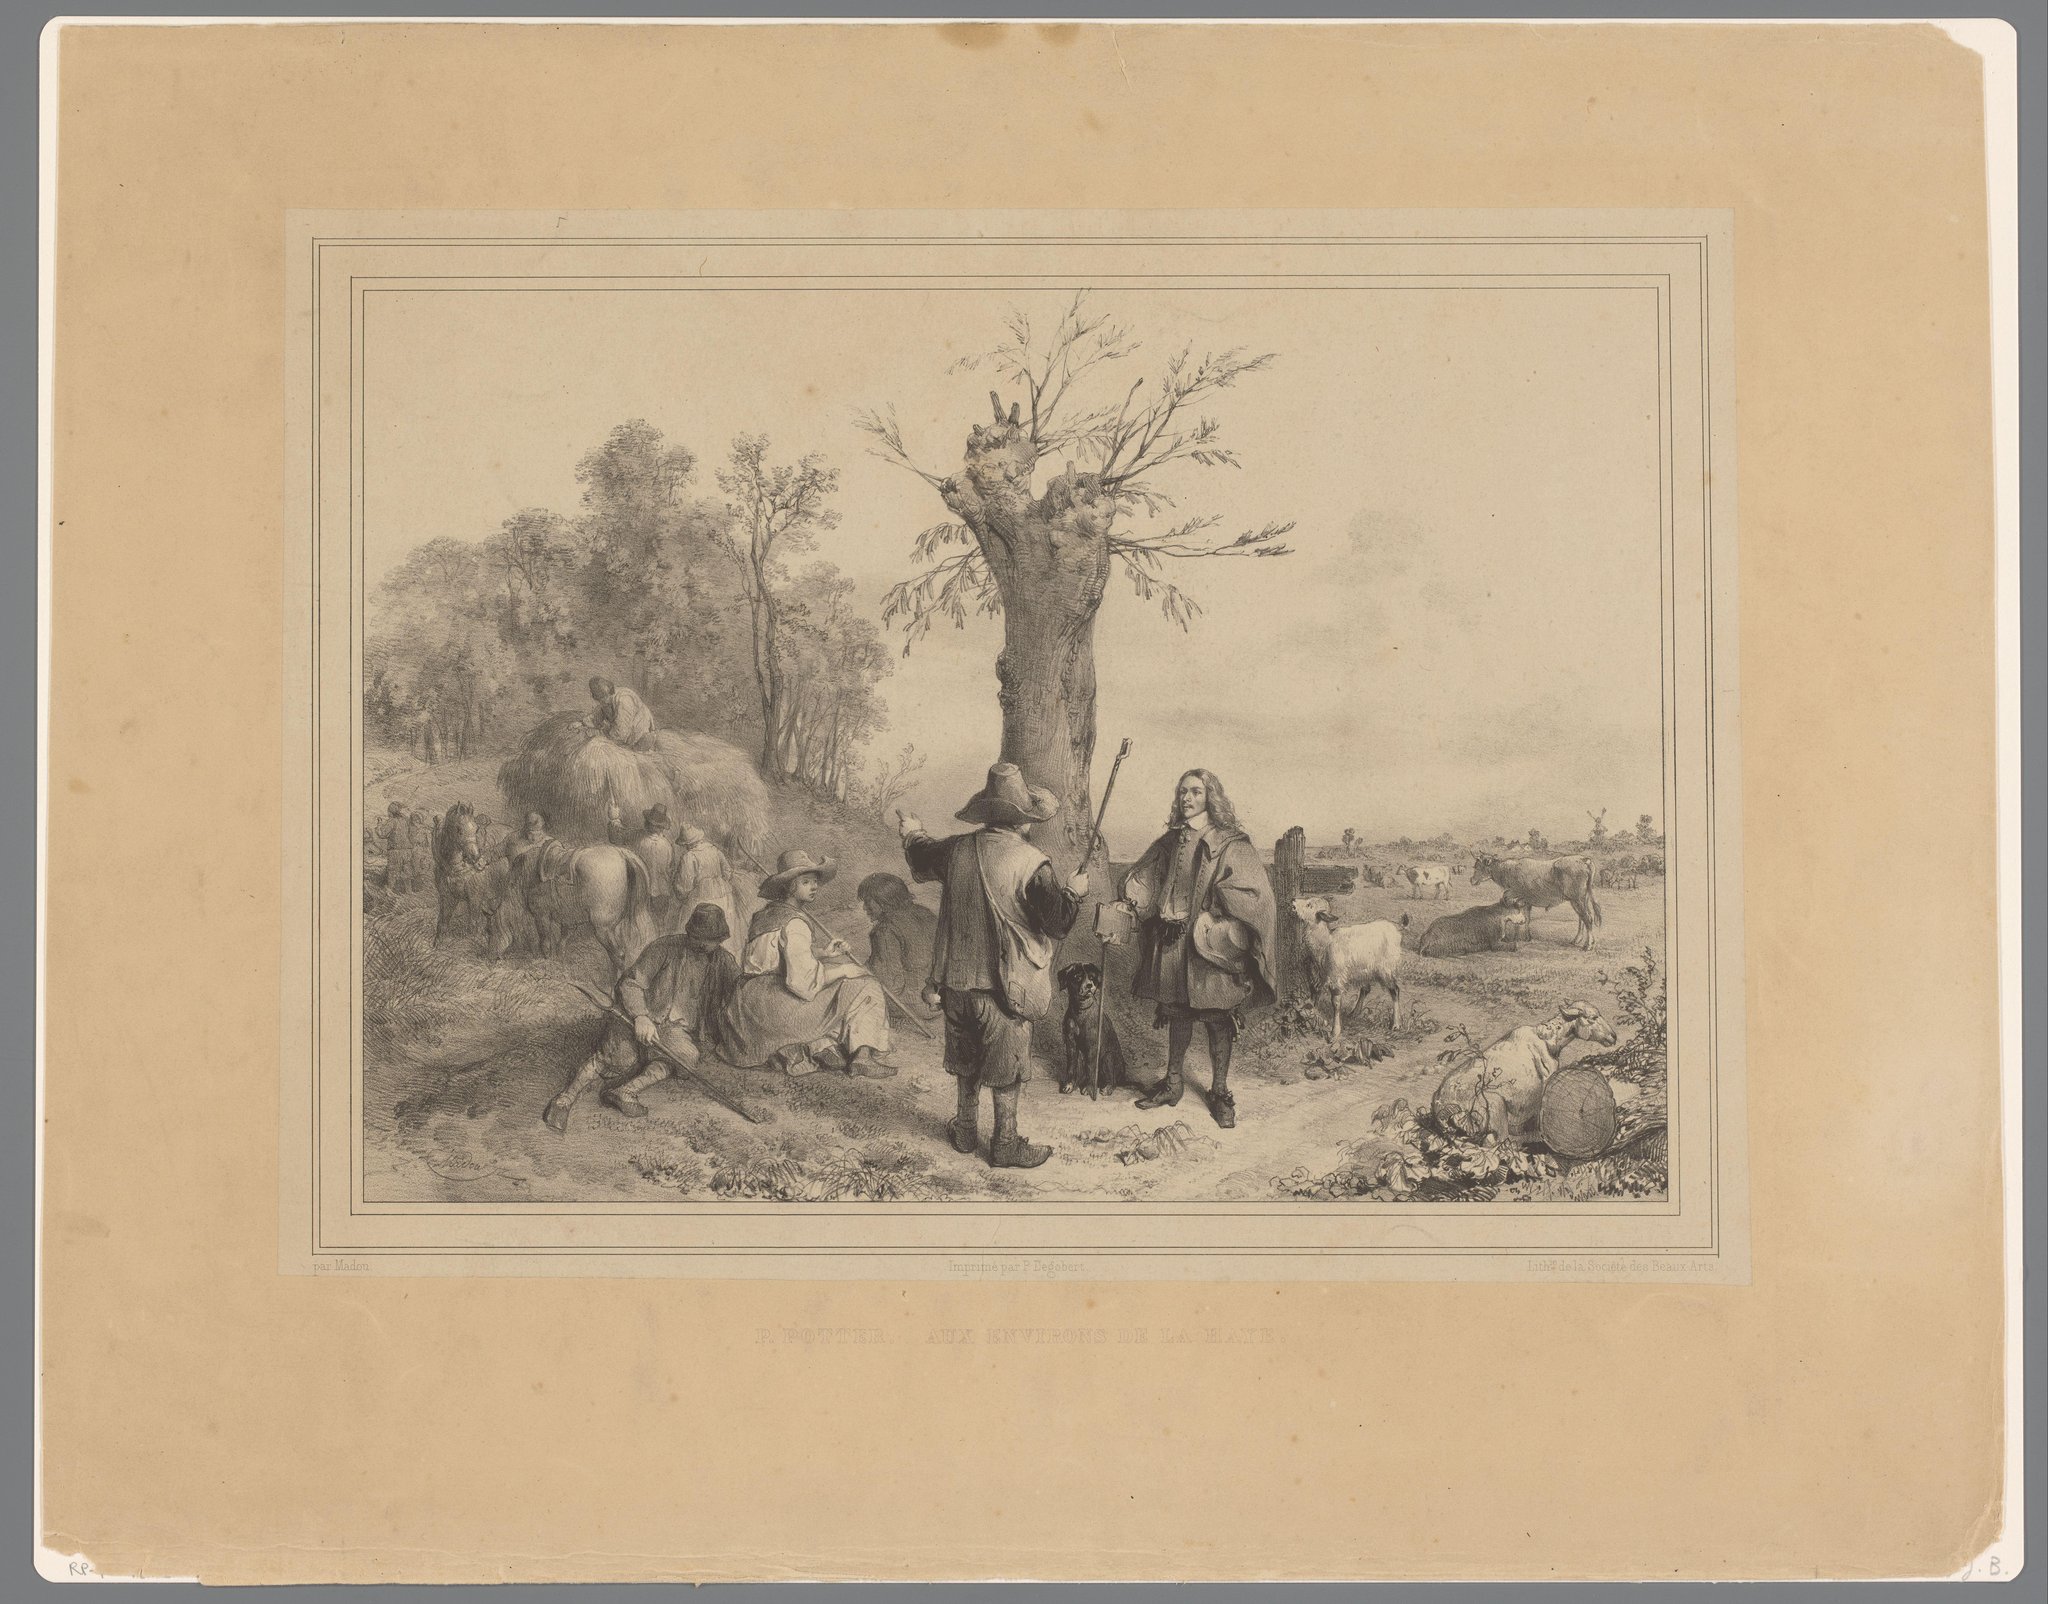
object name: print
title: P. Potter. Aux environs de La Haye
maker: p. degobert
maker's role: printer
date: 1838-1842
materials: paper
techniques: lithograph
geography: brussels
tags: enkhuizen, amsterdam, painter, print maker, draughtsman, paulus potter, landscapes, herding, herdsman, herdswoman, shepherd, shepherdess, cowherd, etc., cattle, artist (in general)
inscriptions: collector's mark: Lugt 2228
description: De serie is verschenen in tien afleveringen van twee platen met bijbehorende tekst tussen 1838 en 1842.